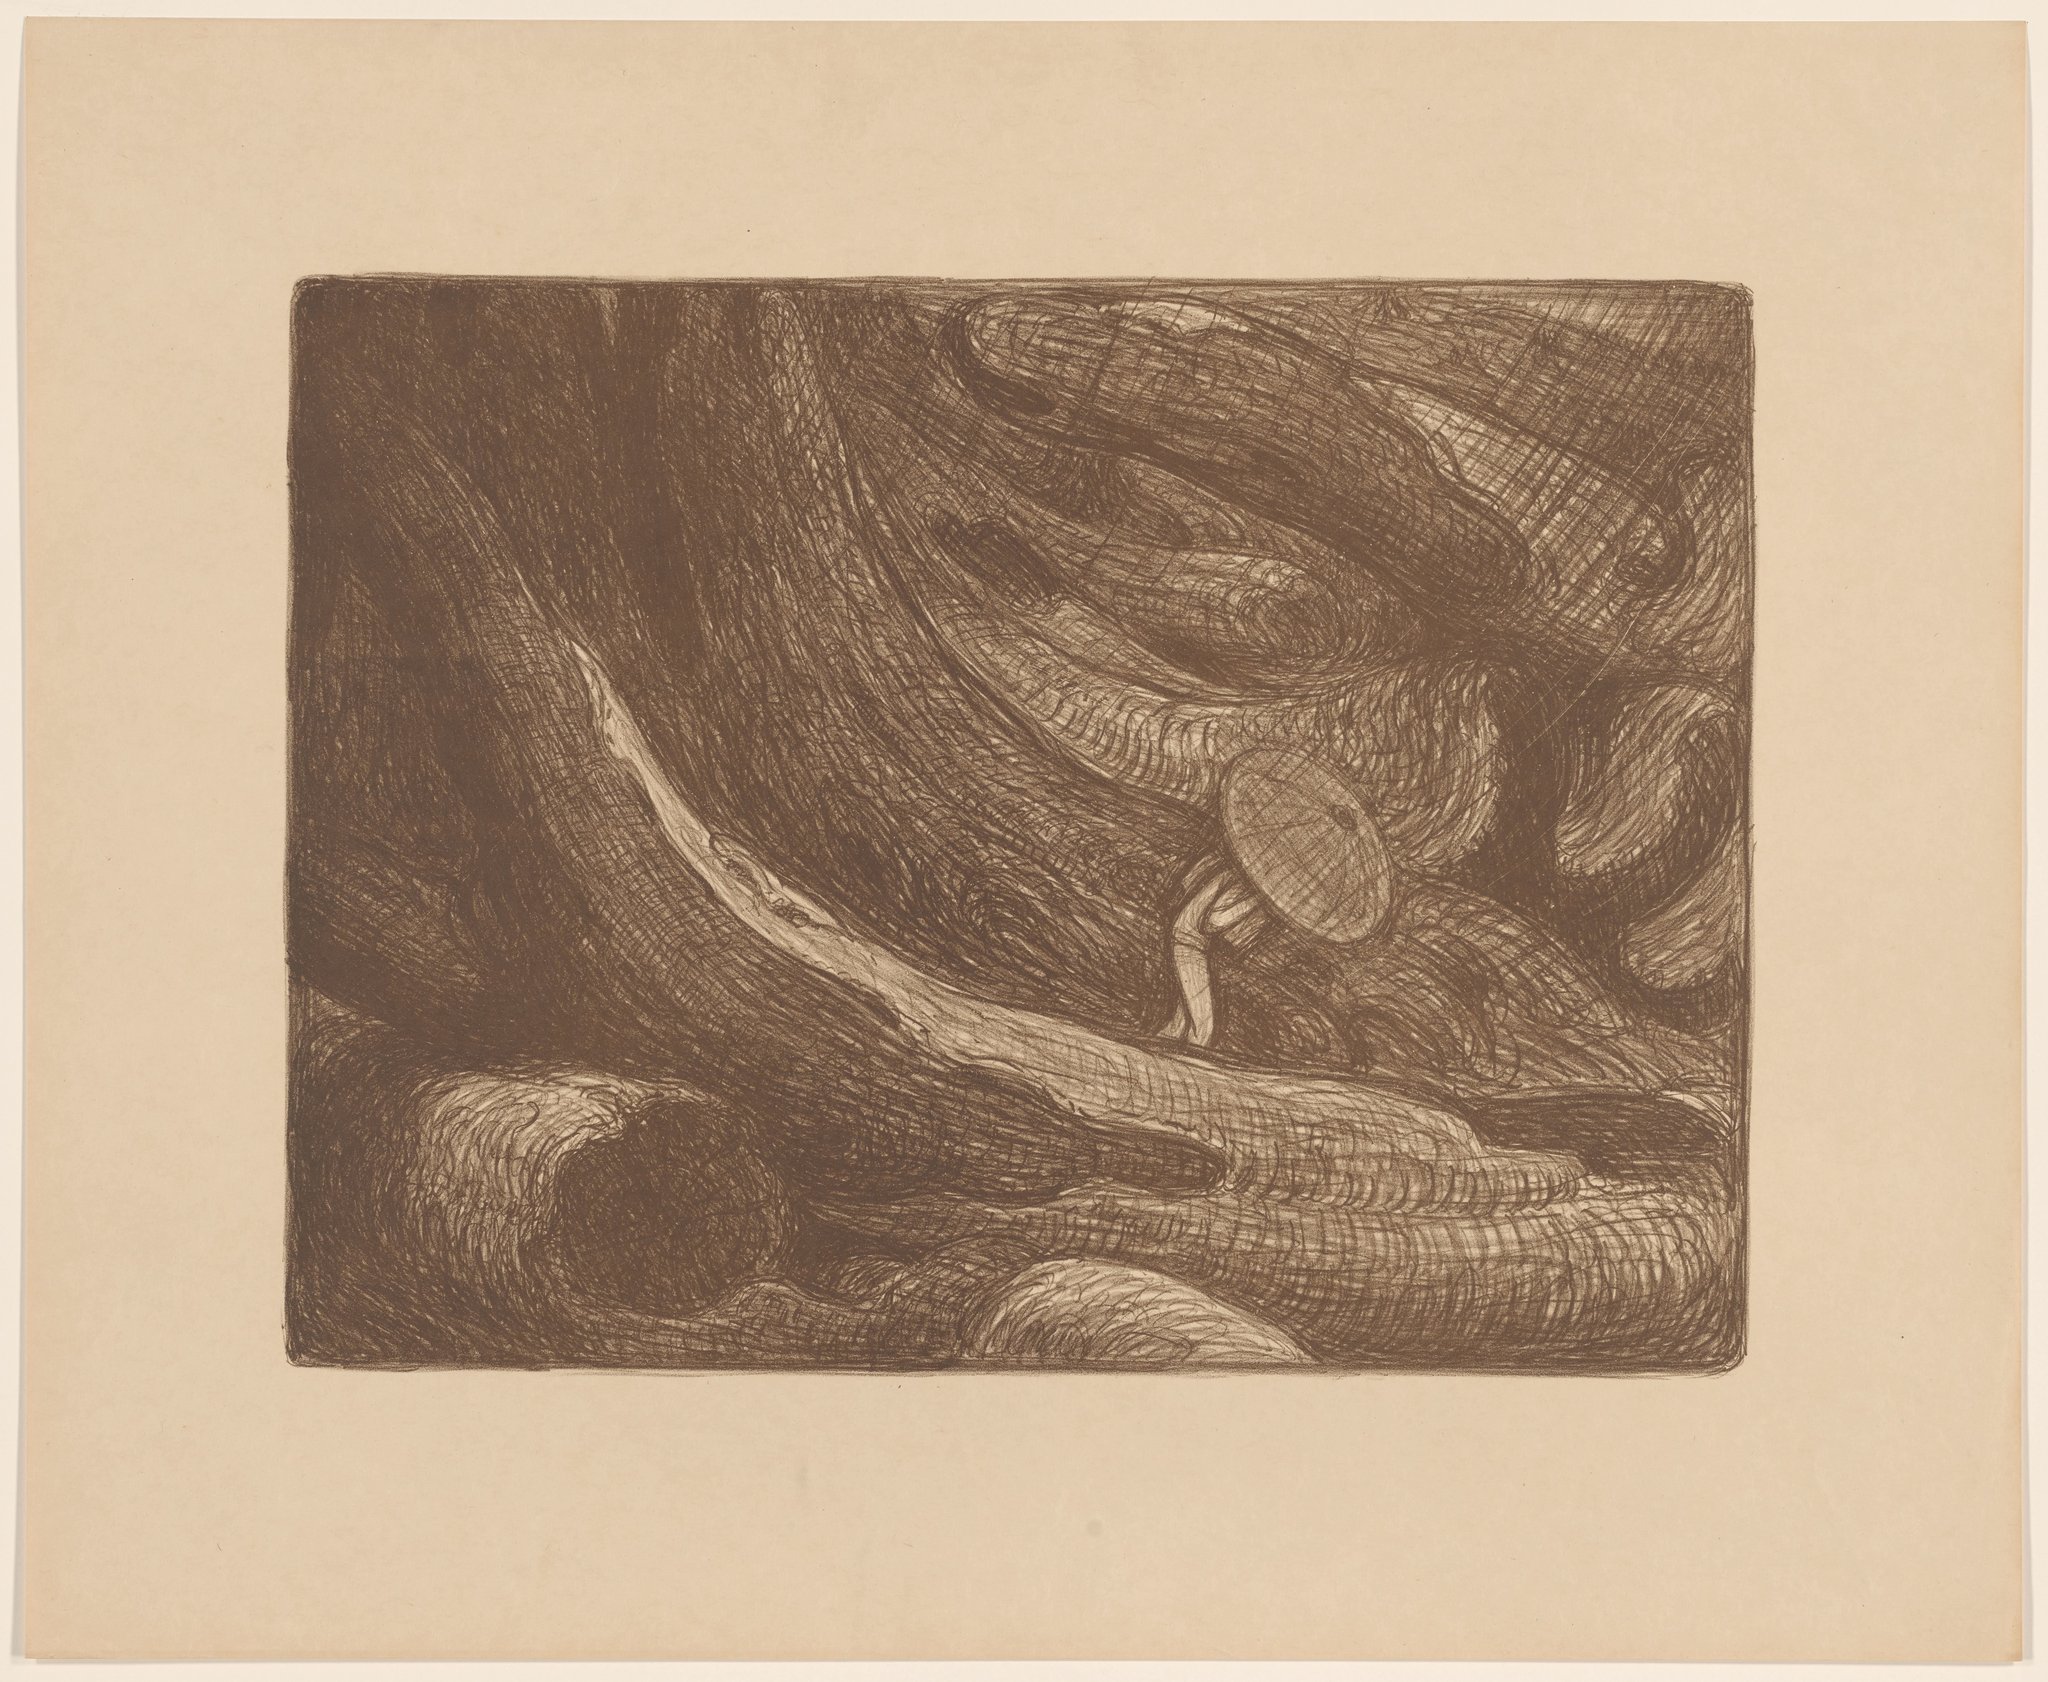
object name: print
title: Vlucht voor de bui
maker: wijnand otto jan nieuwenkamp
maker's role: draughtsman, print maker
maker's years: 1874-1950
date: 1903-1918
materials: paper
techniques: lithograph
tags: downpour, rain shower, trees, umbrella, storm on land, java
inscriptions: collector's mark: Lugt 2228